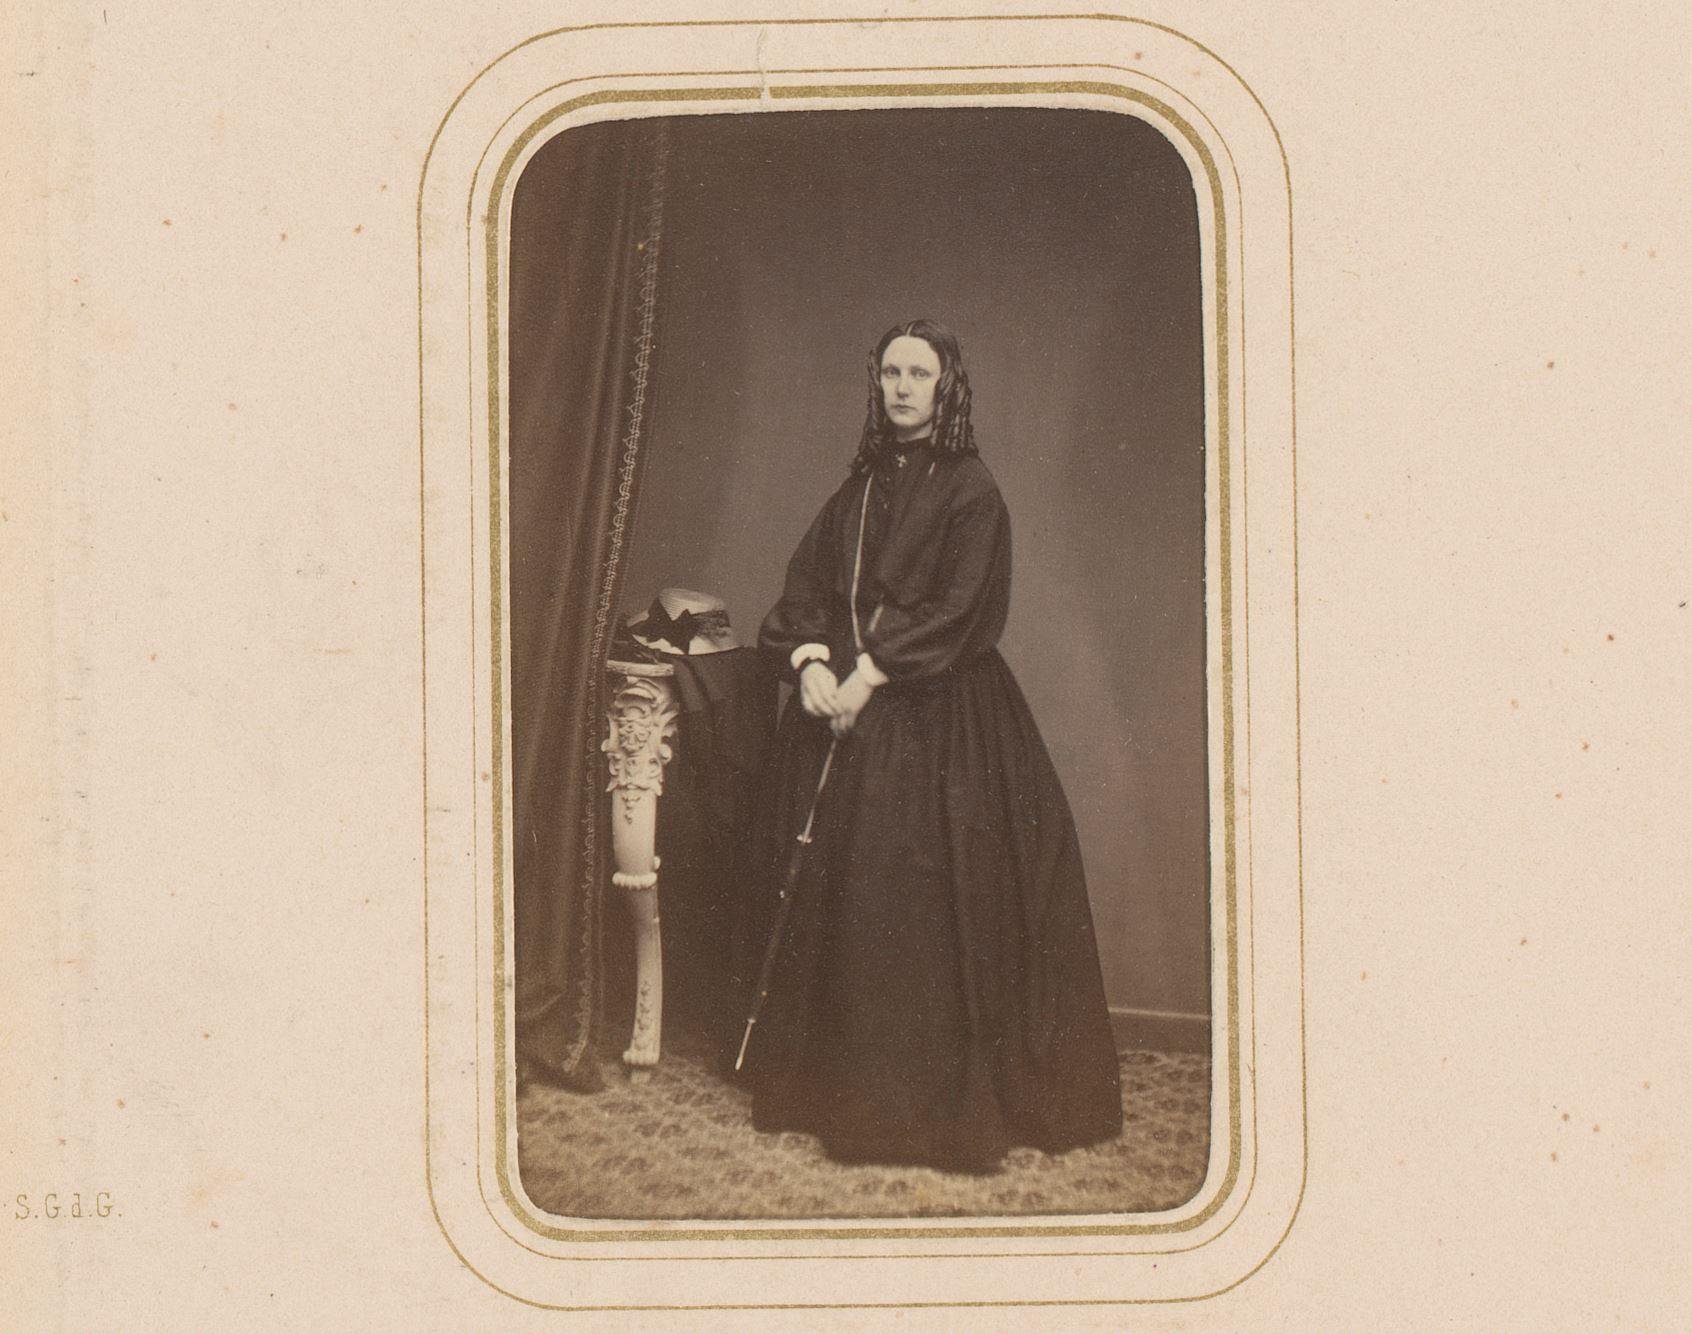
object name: album leaf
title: Portret van een staande vrouw met wandelstok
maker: o.c. smith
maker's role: fotograaf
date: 1860-1900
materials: cardboard, photographic support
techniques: albumen print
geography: stroud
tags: historical persons - bb - woman, walking-stick, staff, standing figure - aa - female human figure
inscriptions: inscription: ‘O. C. SMITH./ STROUD.’